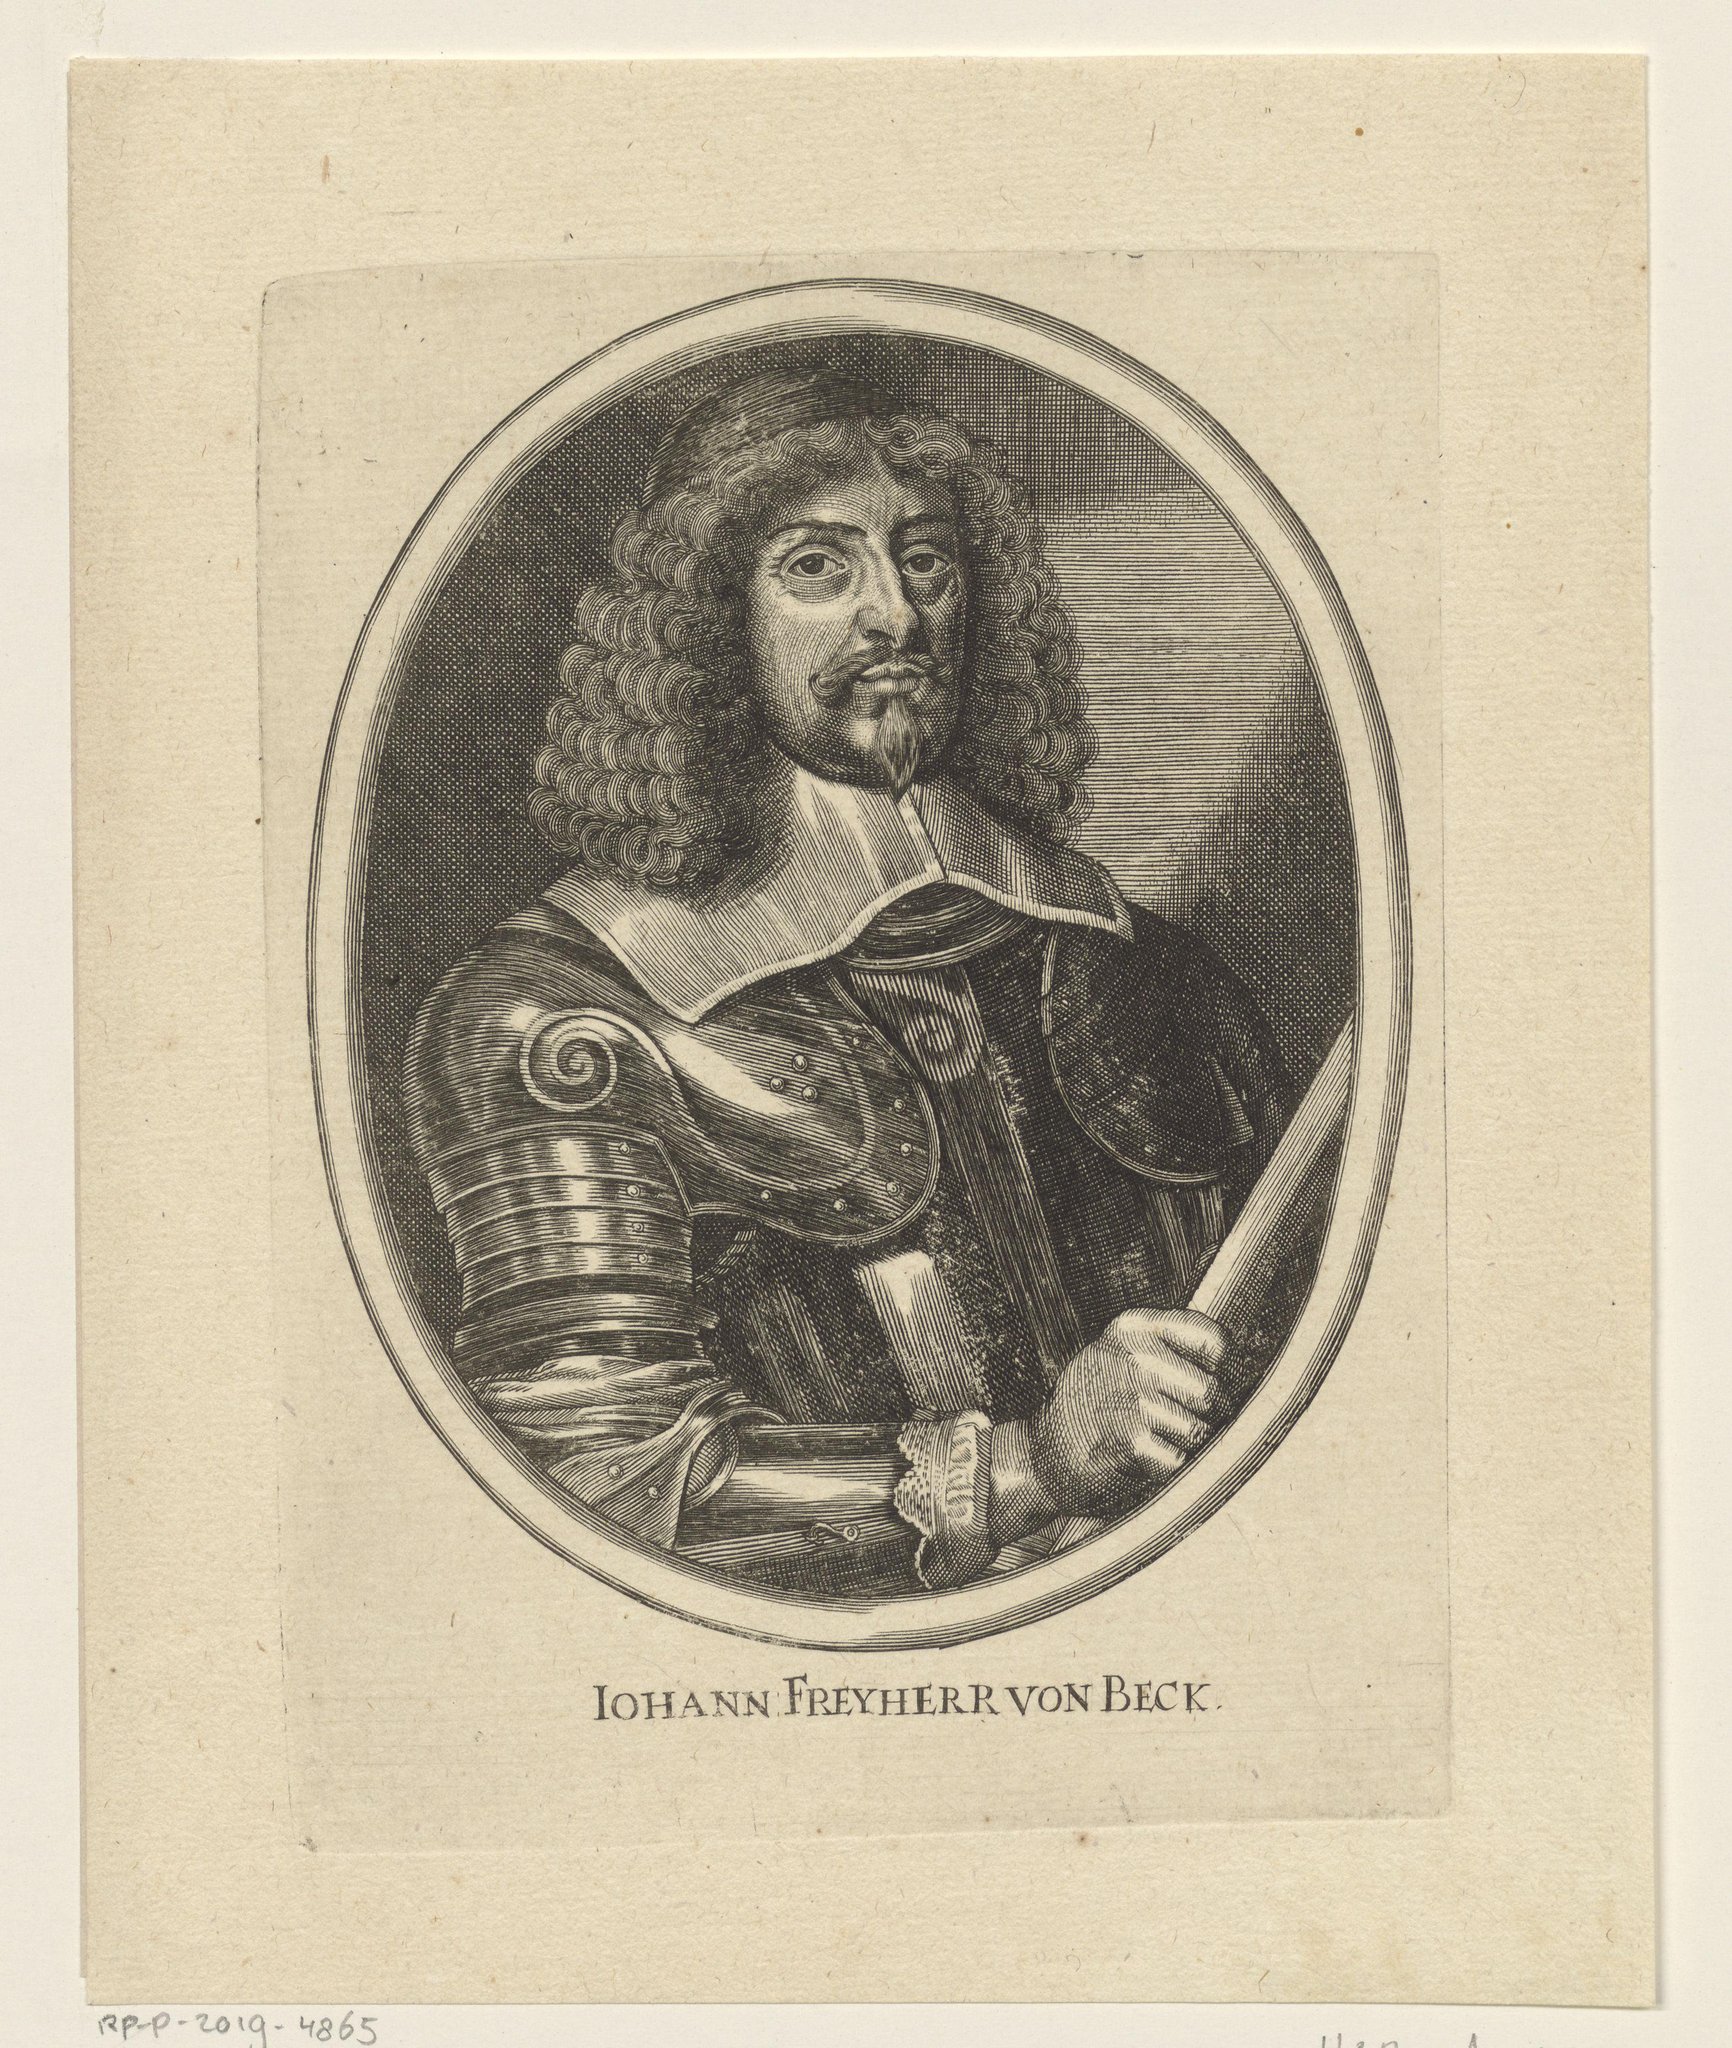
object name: print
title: Portret van Jean de Beck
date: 1647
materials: paper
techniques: engraving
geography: frankfurt am main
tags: armour, historical persons, baton of general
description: Prent met tekst op verso verschenen in: Theatrum Europaeum (...). Frankfurt am Main: Matthäus Merian I, 1647, dl. 5.